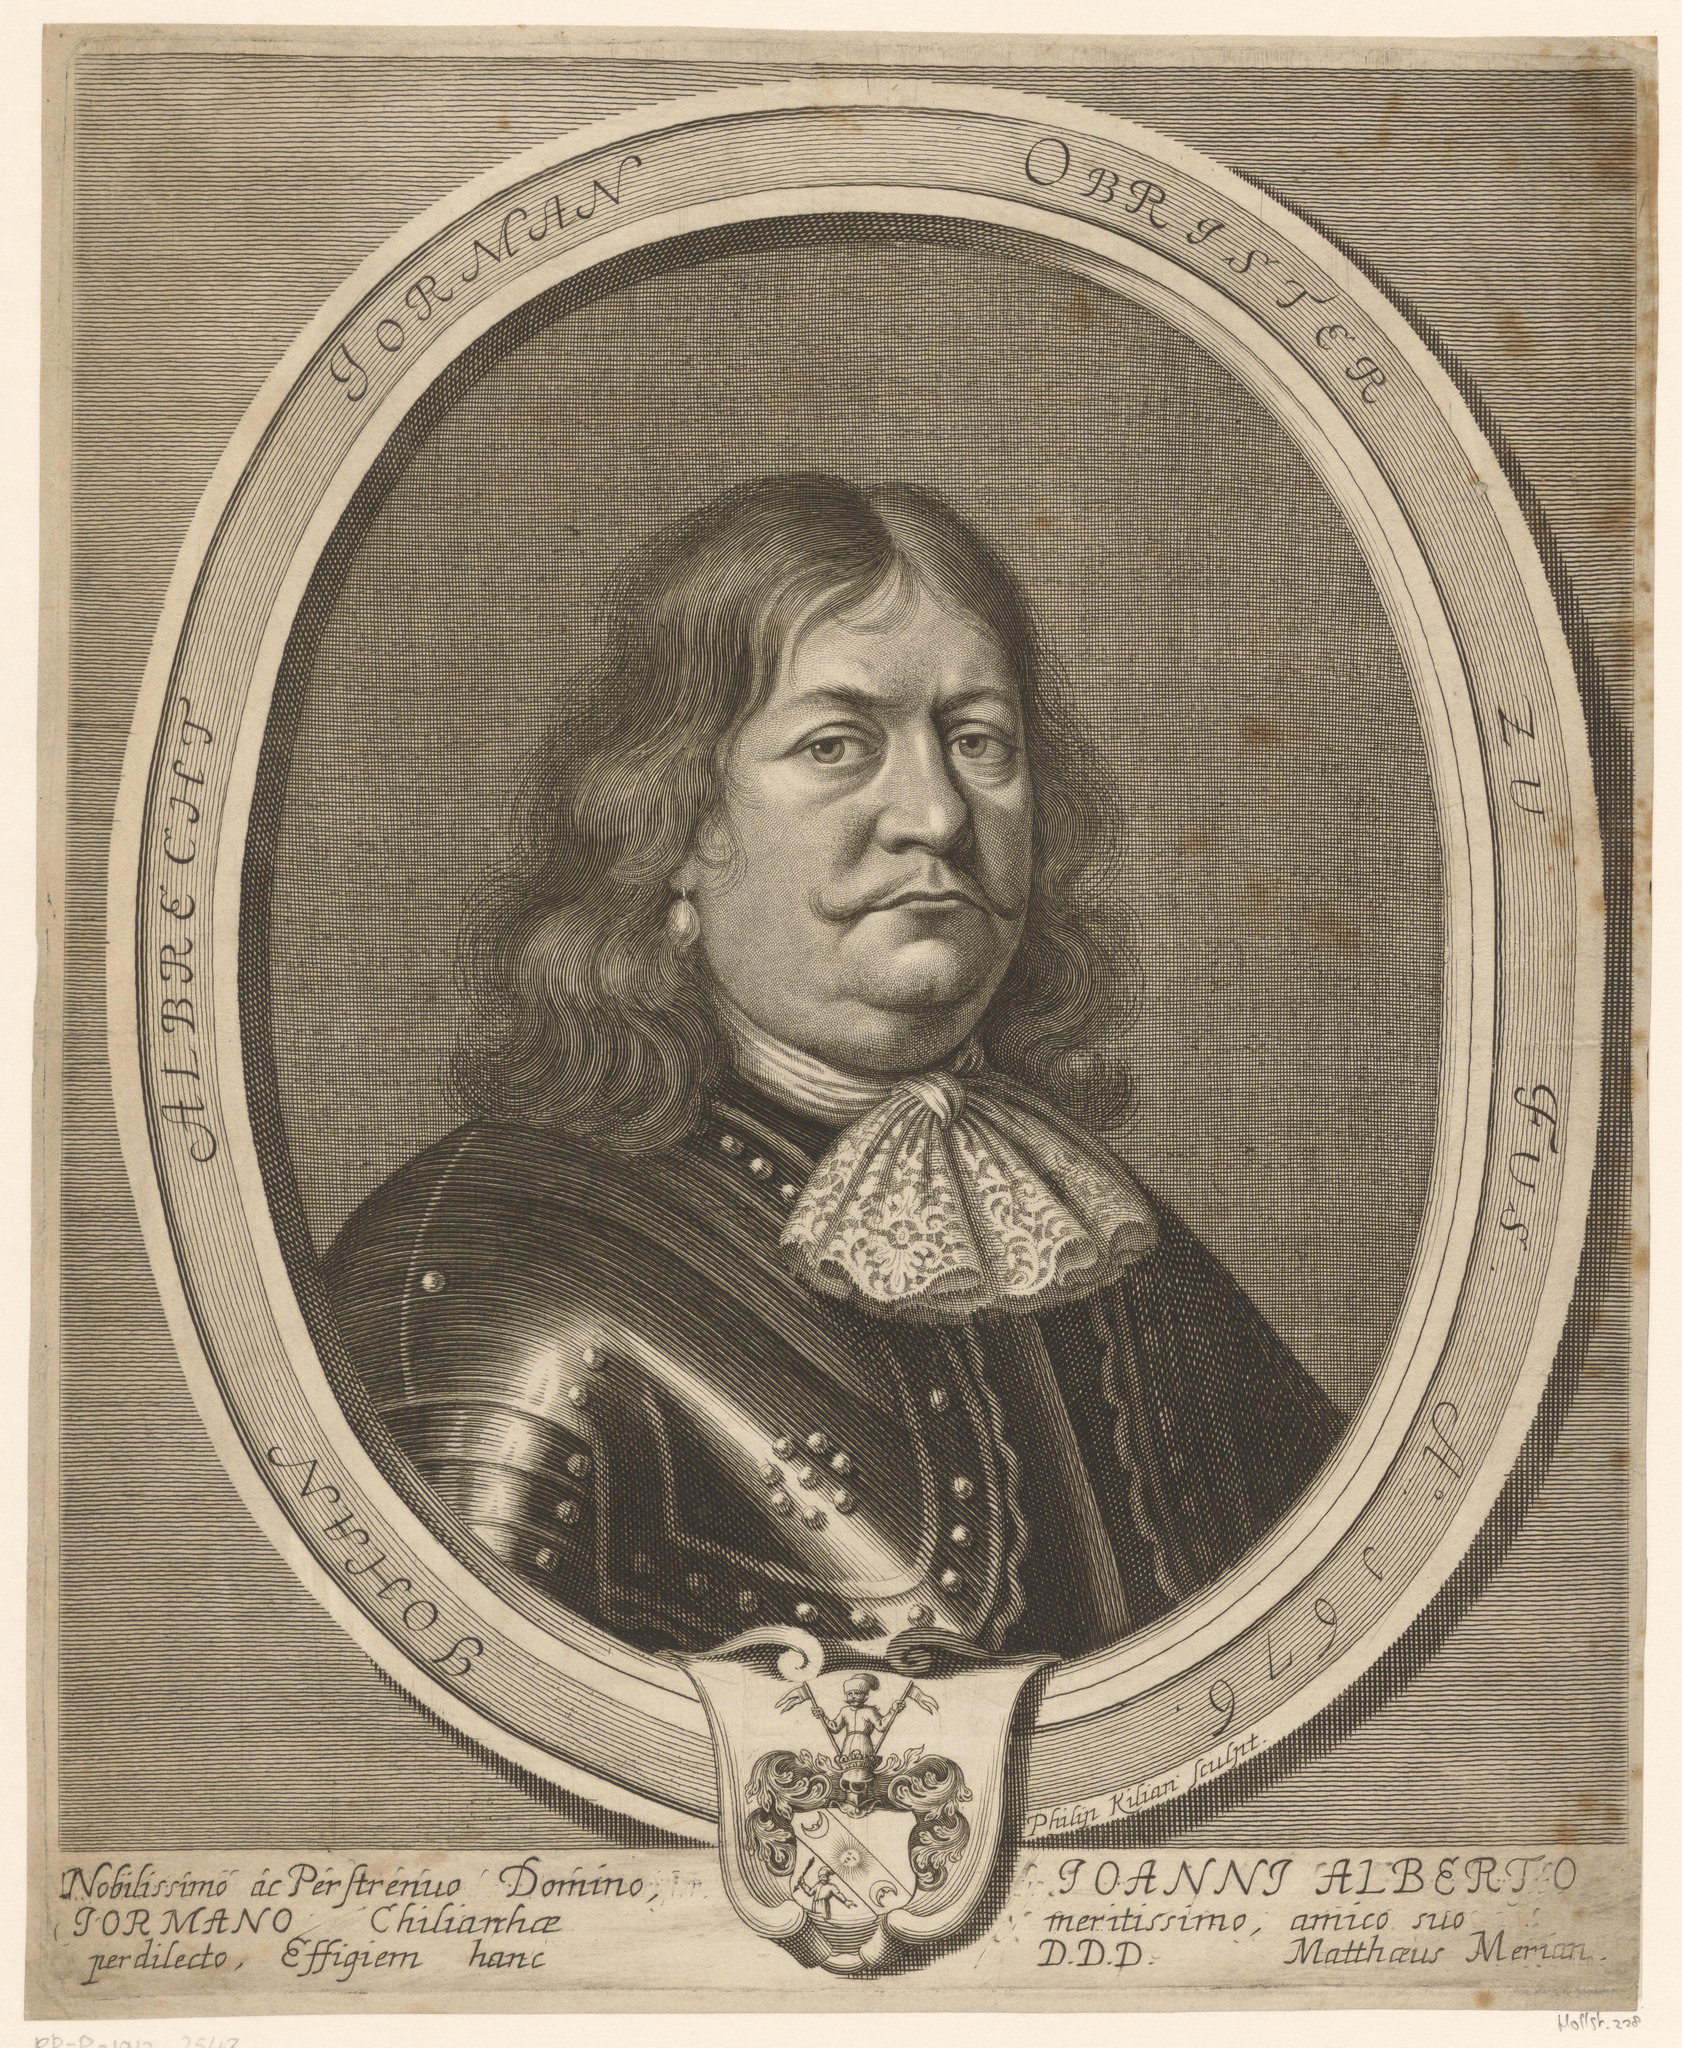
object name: print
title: Portret van Johann Albrecht Jorman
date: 1676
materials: paper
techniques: engraving, etching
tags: johann albrecht jorman, commander-in-chief, general, marshal, historical persons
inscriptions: collector's mark: Lugt 2228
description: Tekst in het Latijn in de omlijsting en in de ondermarge.